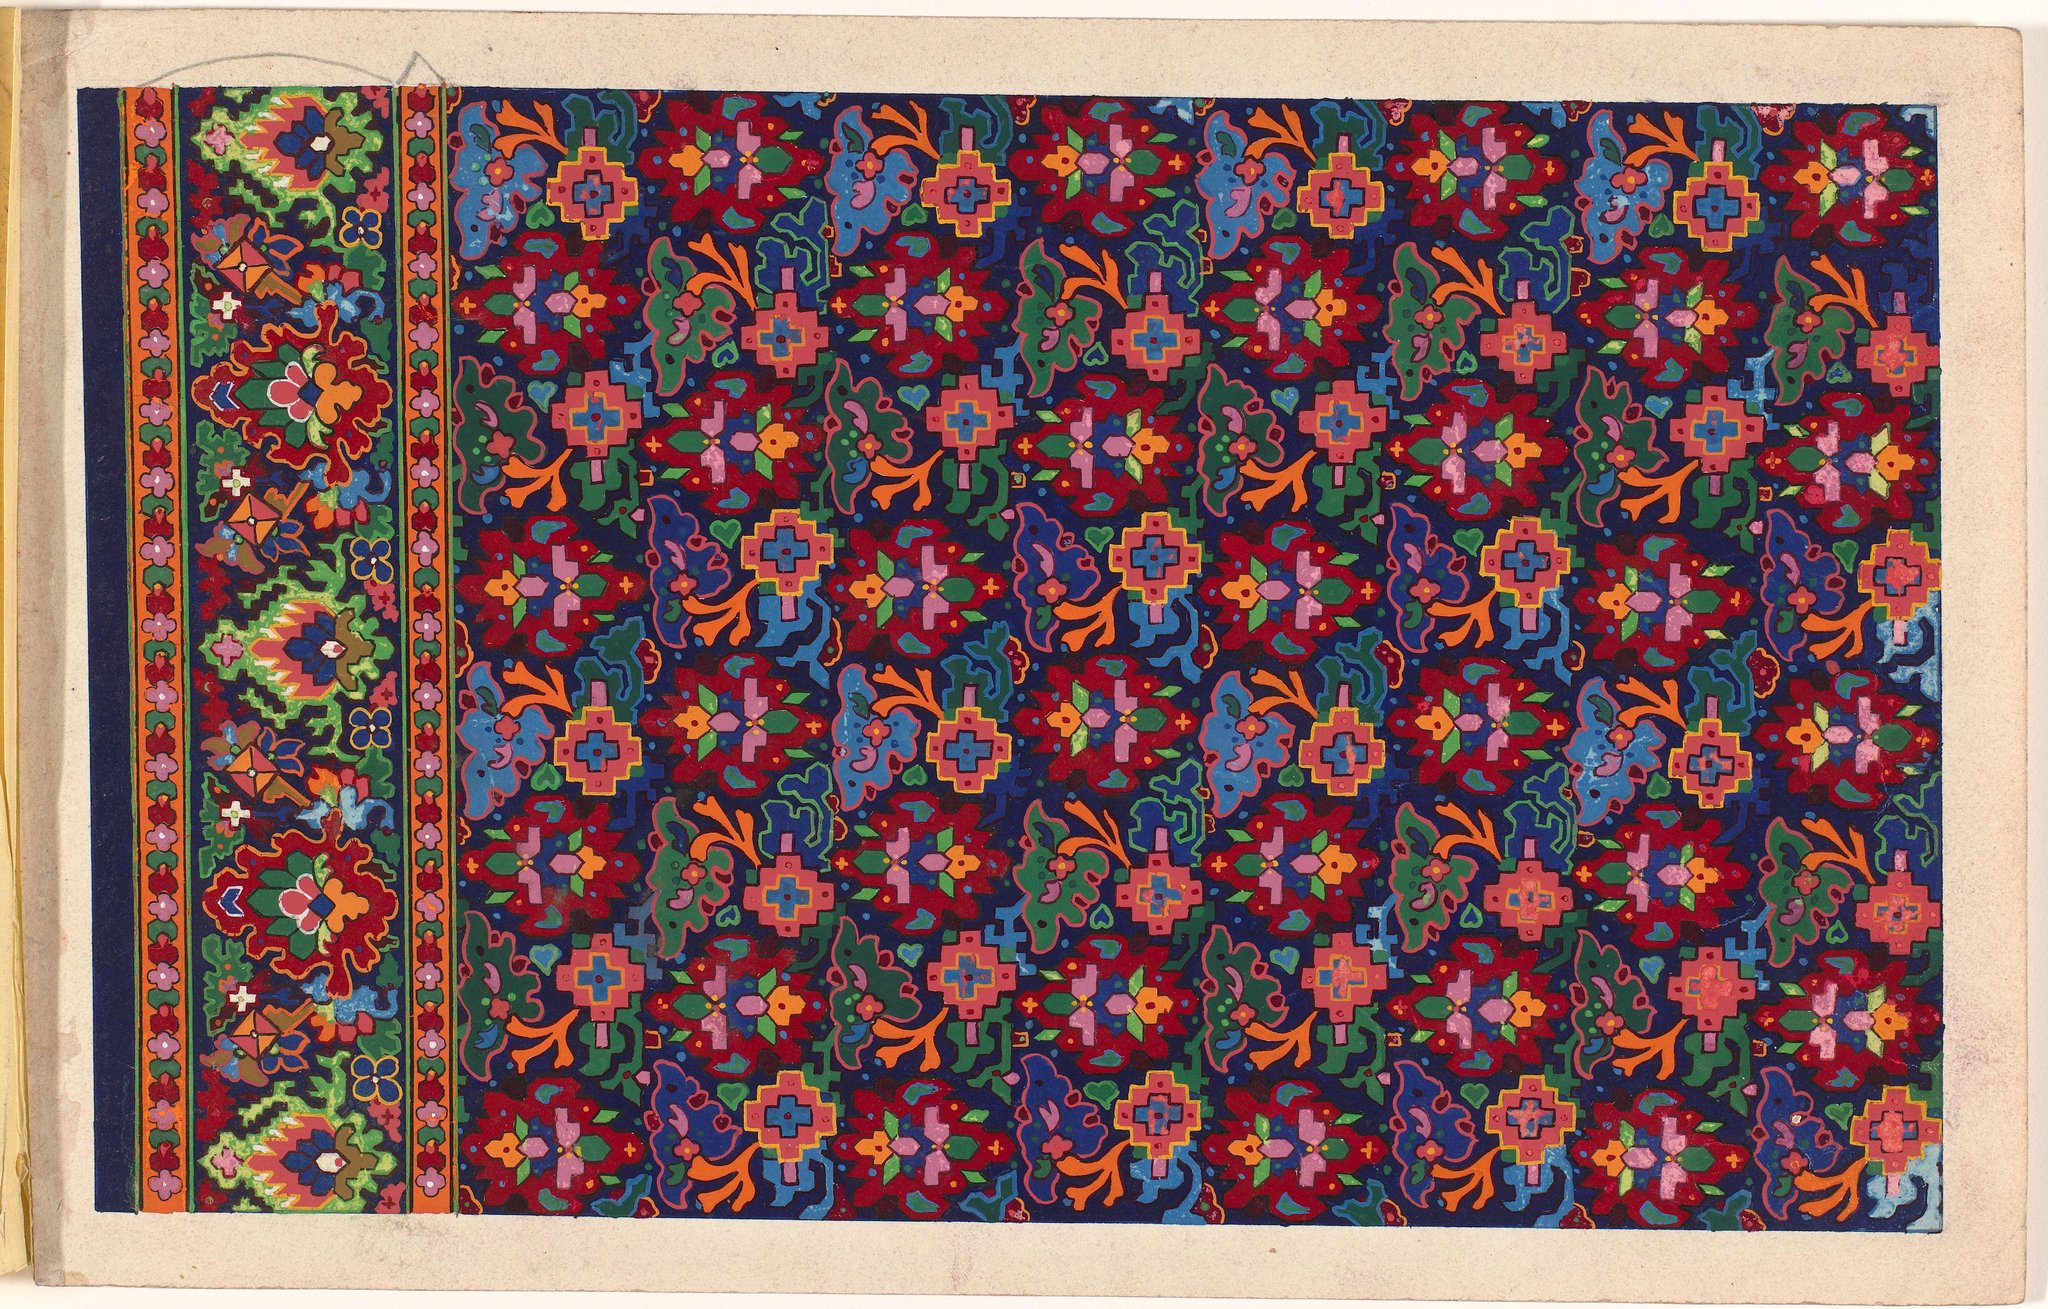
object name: design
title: Ontwerp voor een tapijt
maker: Anonymous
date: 1859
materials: gouache, paper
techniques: brush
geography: amsterdam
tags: ornaments ~ art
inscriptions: stamp: ‘Koninklyke Tapytfabriek Firma P. van Calcar & Co’, retailer's mark: ‘J.H. SMAALE Jr/ Amsterdam.’, retailer's mark: ‘JHS.’, inscription: ‘April 1859’, number: ‘No 424/ V.’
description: De presentatietekeningen BK-1971-77-1 t/m 86 zijn kopieën van de originele ontwerptekeningen. Ze werden gemaakt voor vertegenwoordigers van bijvoorbeeld magazijnen, die ze aan hun klanten konden tonen. De meeste tekeningen tonen een kwart van het dessin inclusief rand, middenpartij (de zogenaamde grond of fond) en centraal medaillon. Door het gebruik van spiegels kan de illusie van het gehele tapijt worden opgeroepen. Een deel van de tekeningen heeft een alfabetische opeenvolgende letter als kenmerk, de andere groep een cijfer.Waarschijnlijk is de reeks dessins met een letter eerder samengesteld dan de genummerde tekeningen.